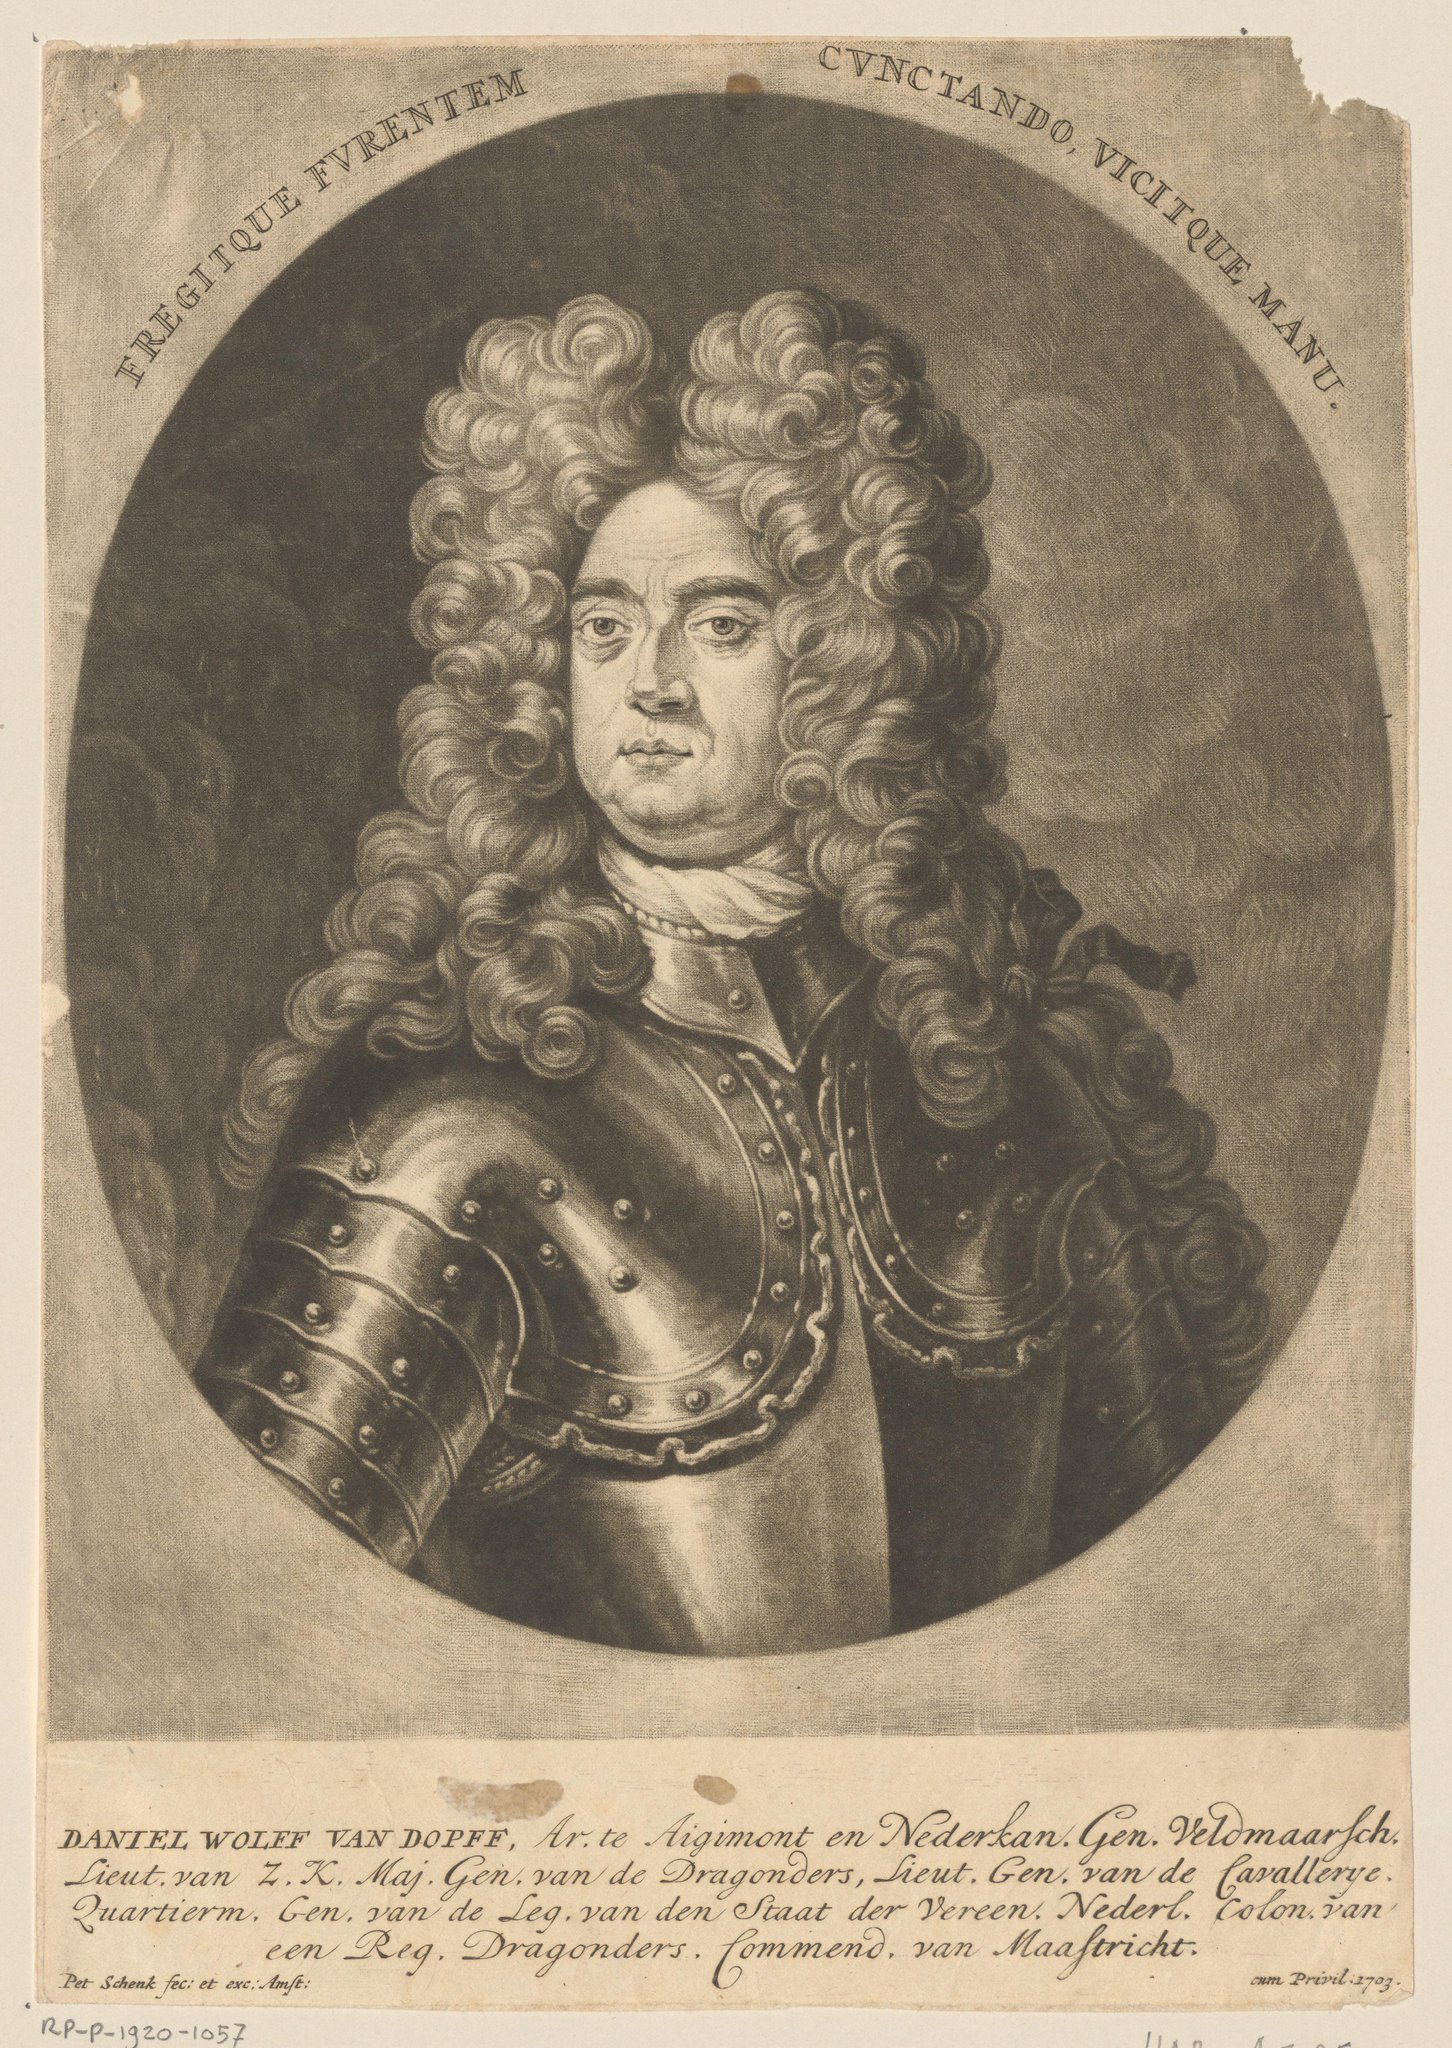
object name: print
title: Portret van Daniel Wolff van Dopff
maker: pieter schenk (i)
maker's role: print maker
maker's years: 1660-1711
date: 1703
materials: paper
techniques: engraving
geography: amsterdam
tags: commander-in-chief, general, marshal, historical persons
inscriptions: collector's mark: Lugt 2228